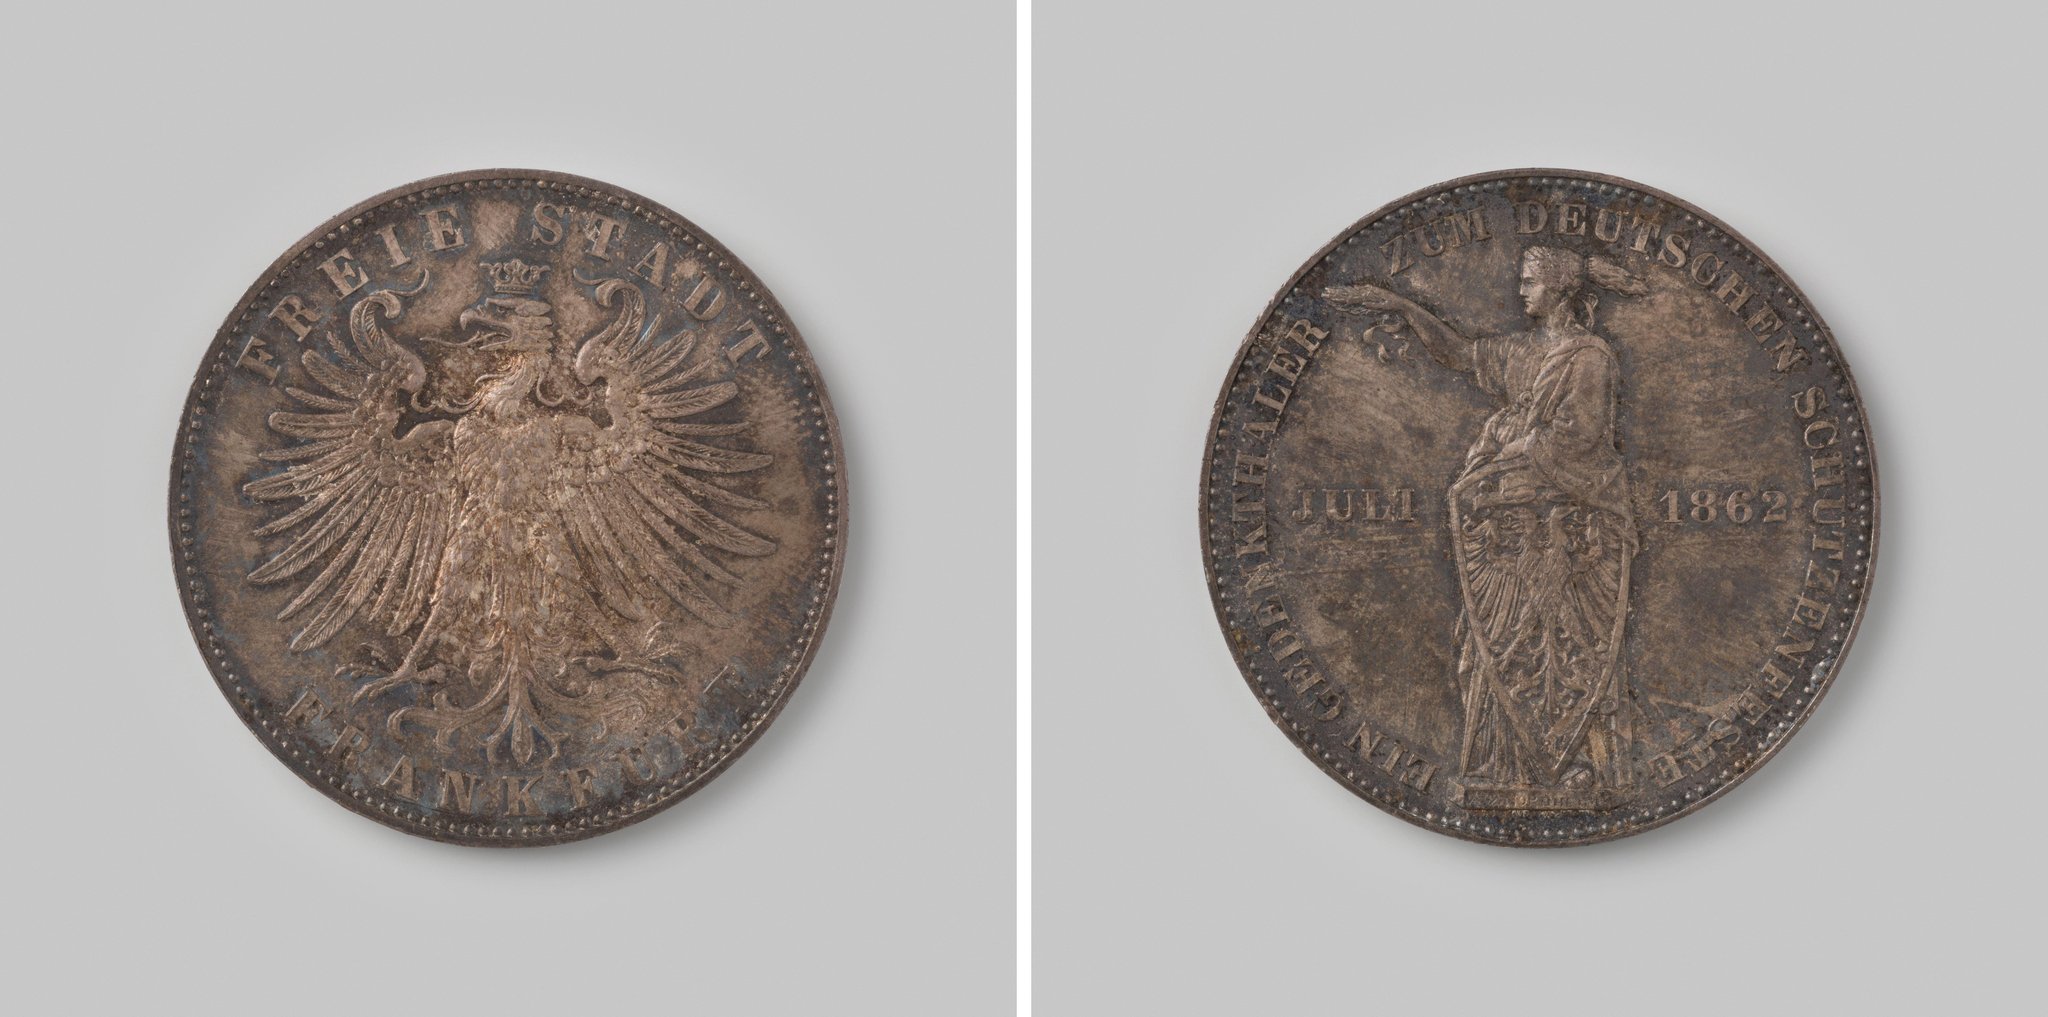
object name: herdenkingstaler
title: Vrije rijksstad Frankfurt am Main, gedenkthaler, 1862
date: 1862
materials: silver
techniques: striking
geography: frankfurt am main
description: Zilveren munt. Voorzijde: gekroonde enkelkoppige adelaar. Keerzijde: tussen maand en jaartal staande vrouw naar links met voor haar wpenschild van de stad.Waarde-aanduiding EIN GEDENKTHALER in omschrift. Randschrift.